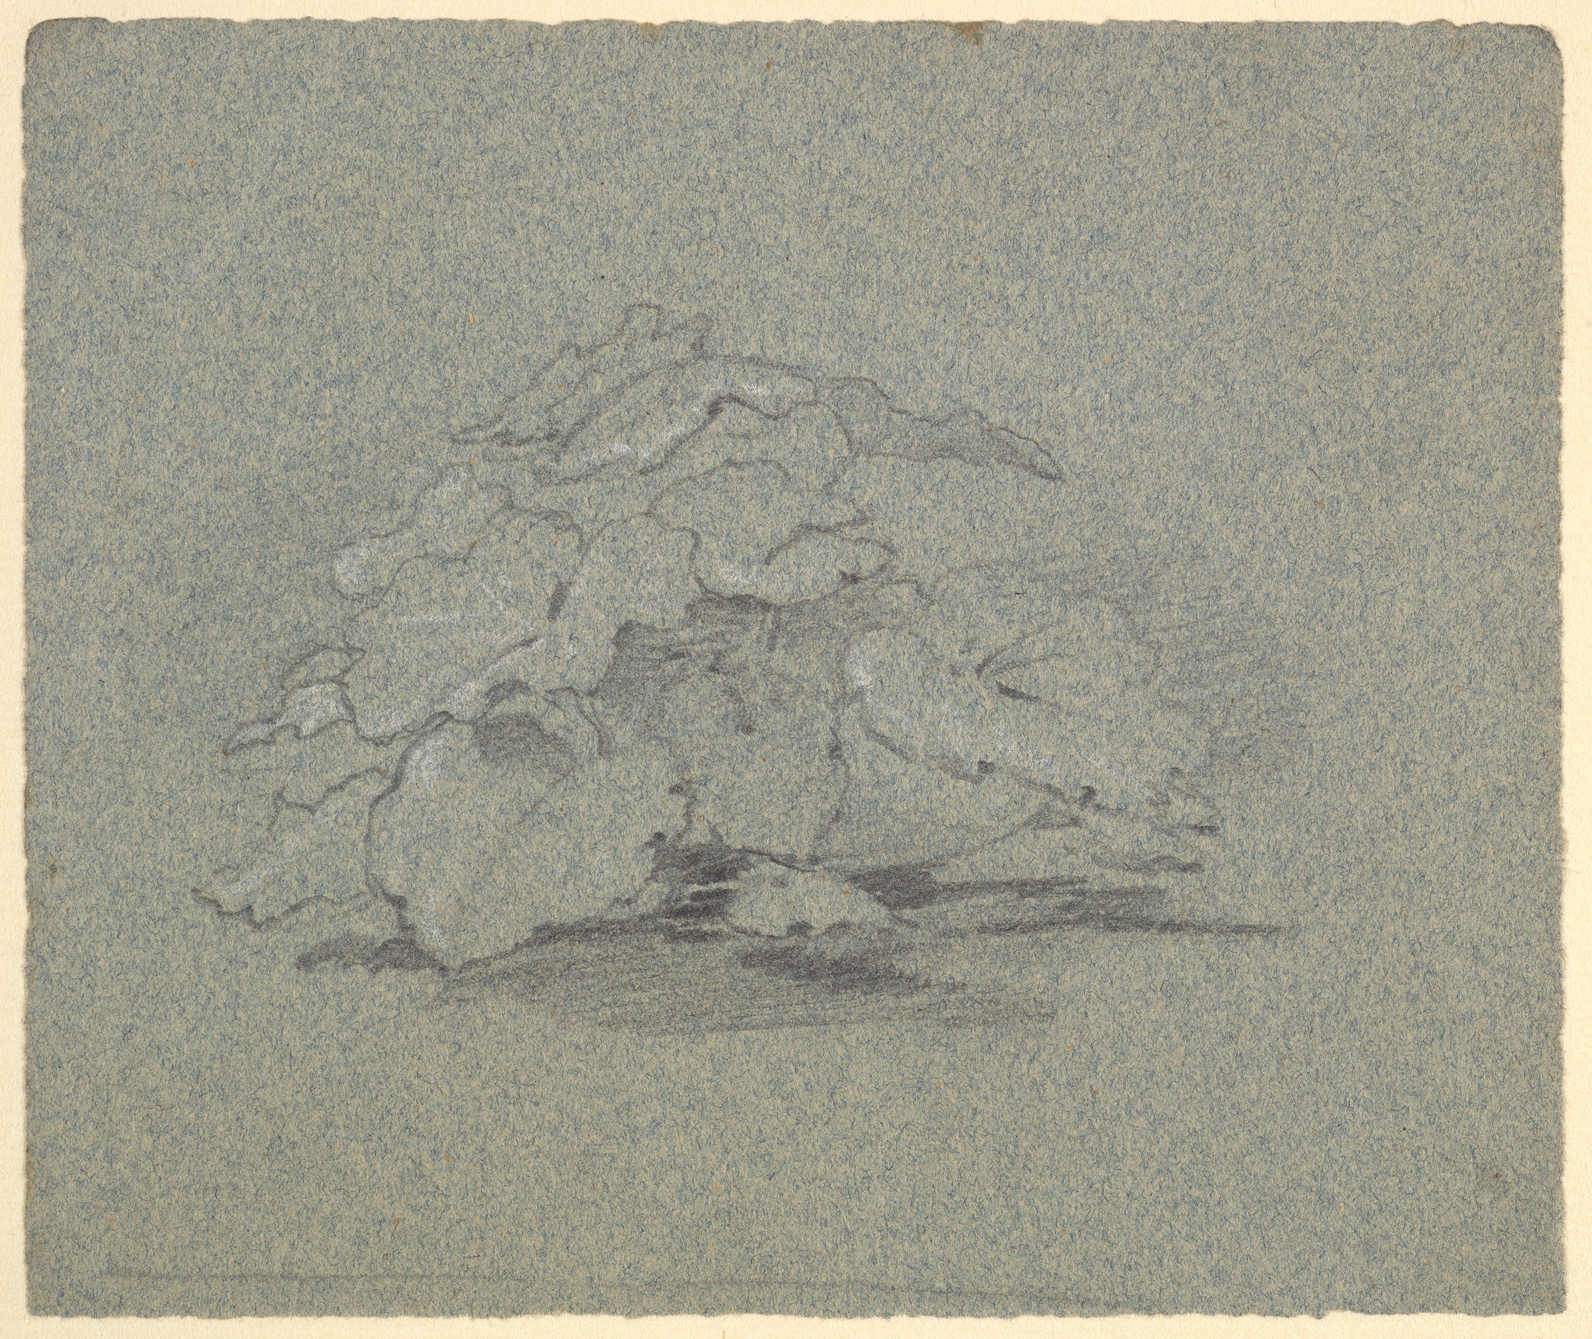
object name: drawing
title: Burdock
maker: george richmond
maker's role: artist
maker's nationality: british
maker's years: 1809-1896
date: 1820-1890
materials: chalk, paper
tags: abstraction